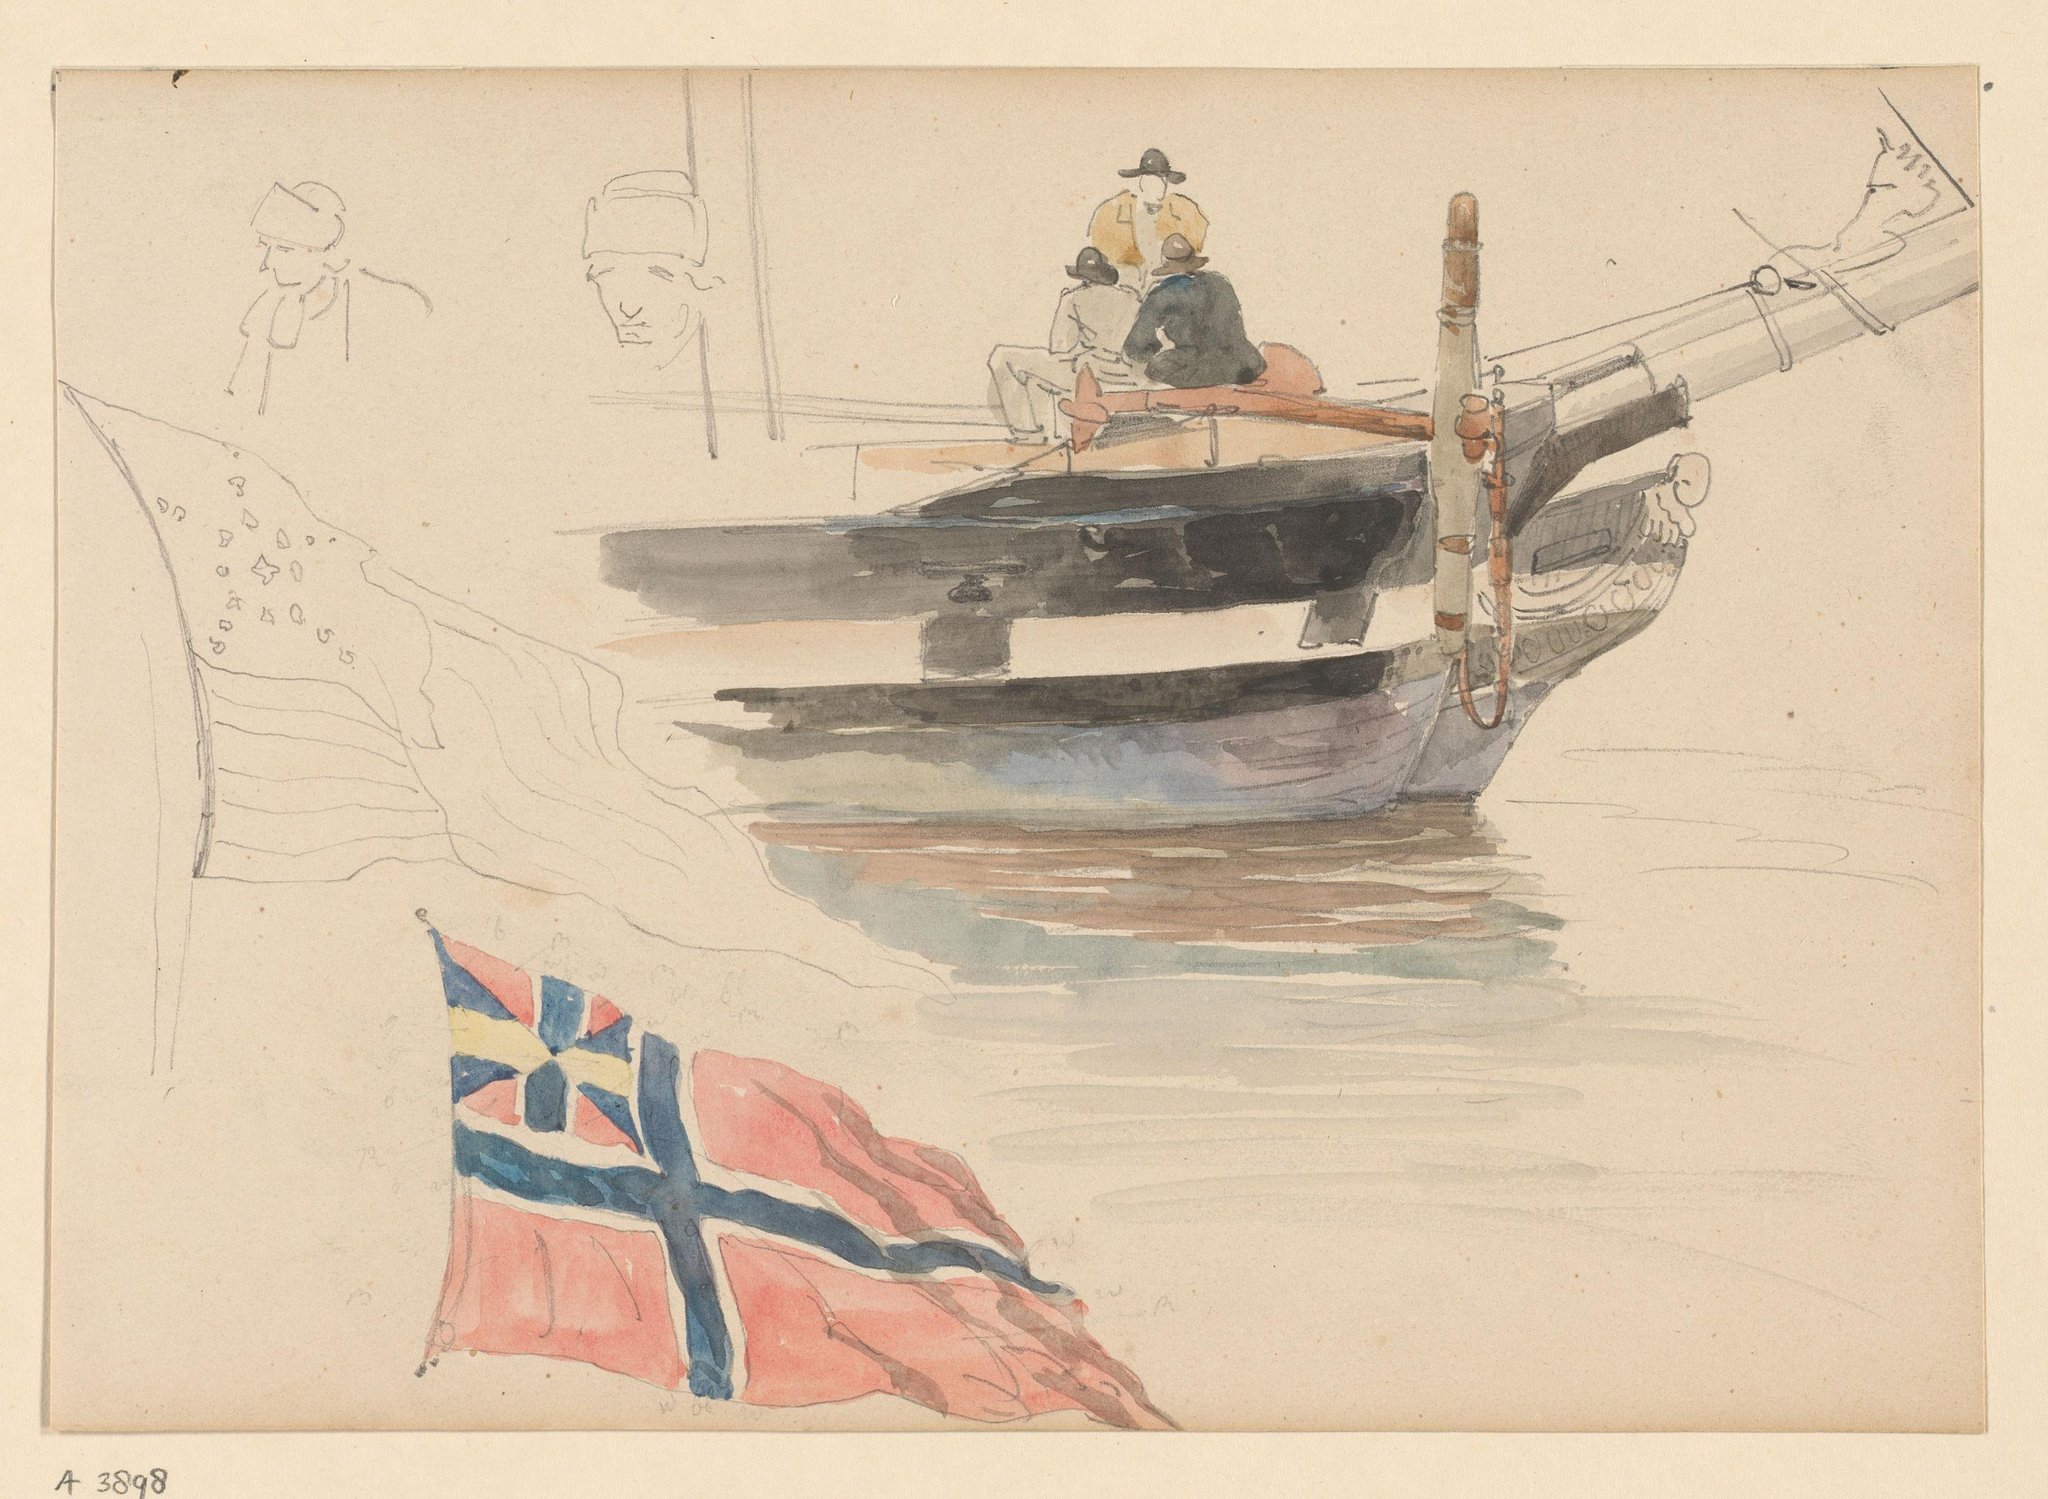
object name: watercolor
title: Studies van vlaggen en een boot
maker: willem anthonie van deventer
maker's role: draughtsman, painter, print maker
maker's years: 1824-1893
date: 1834-1893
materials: paper, pencil, watercolor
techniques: brush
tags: sailing-ship, sailing-boat, flag, colours (as symbol of the state, etc.)